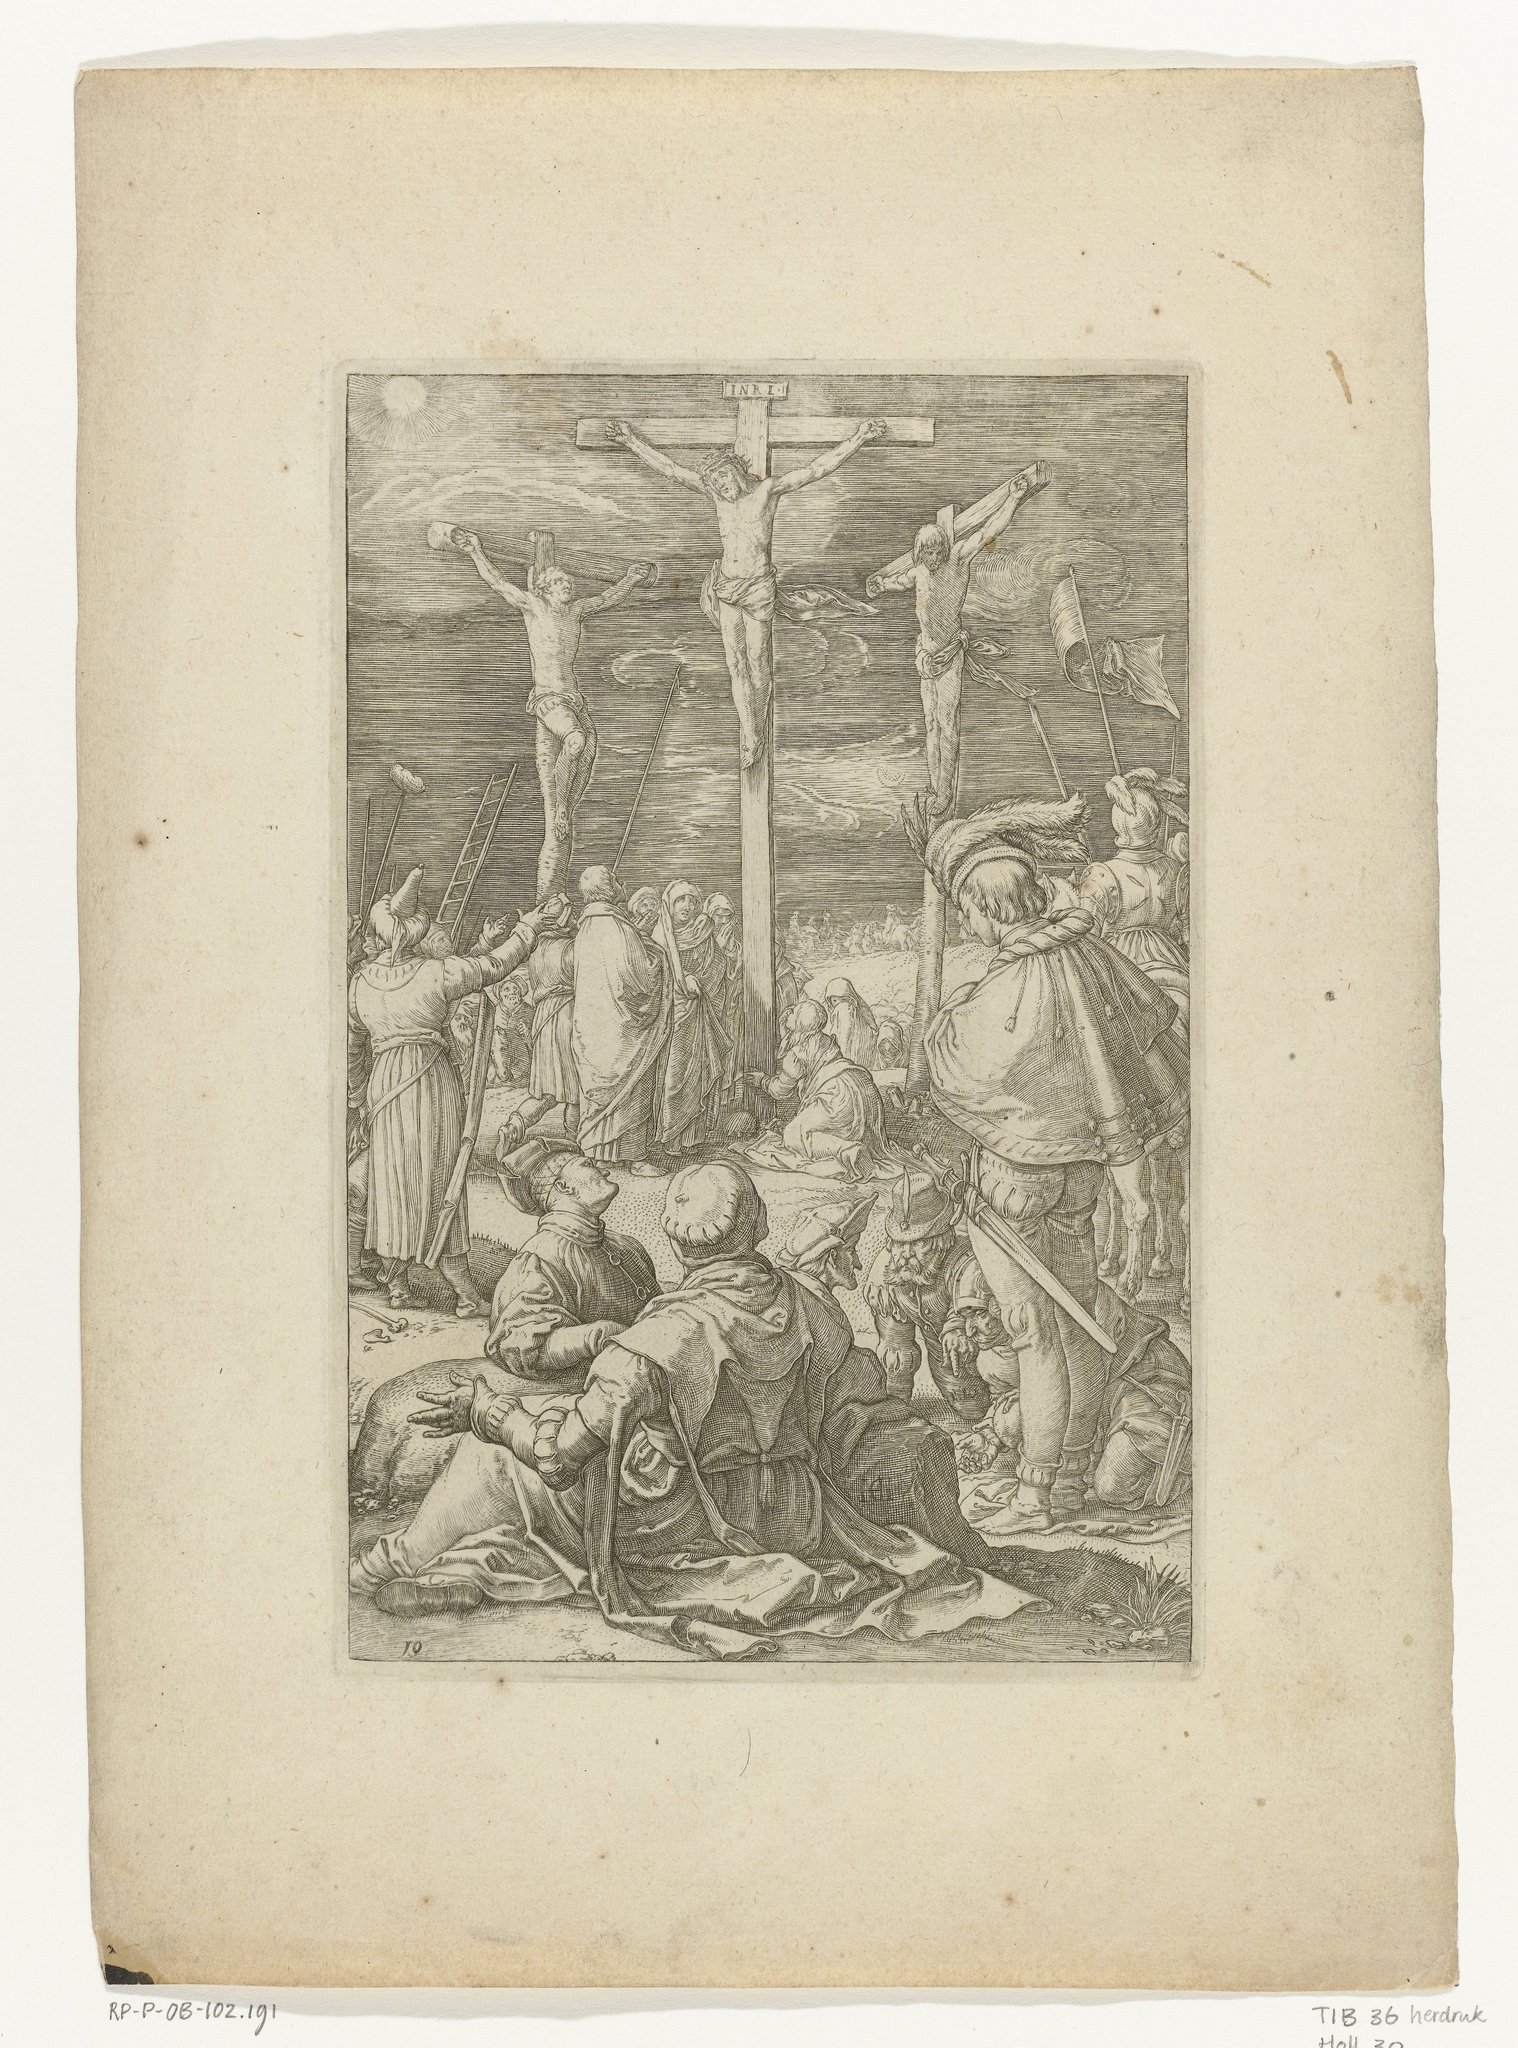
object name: print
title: Christus aan het kruis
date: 1596-1598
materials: paper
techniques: engraving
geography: haarlem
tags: the crucifixion of christ: christ's death on the cross; golgotha (matthew 27:45-58; mark 15:33-45; luke 23:44-52; john 19:25-38)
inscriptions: collector's mark: Lugt 2228, monogram: ‘HG’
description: De twaalf bladen van deze serie zijn gegraveerd in de stijl van Lucas van Leyden, maar ook komen delen van de composities overeen met gedeeltes van Dürers Passie. Er bevindt zich een ongedateerde tekening die gediend heeft als model voor de prent in het Museum für Bildende Kunst in Leipzig (afgebeeld in Reznicek, zie literatuur). Jacobs, G. Dit is mogelijk een herdruk van de gesleten originele platen, uitgever J.G. Hasselberg, Berlijn 1854.